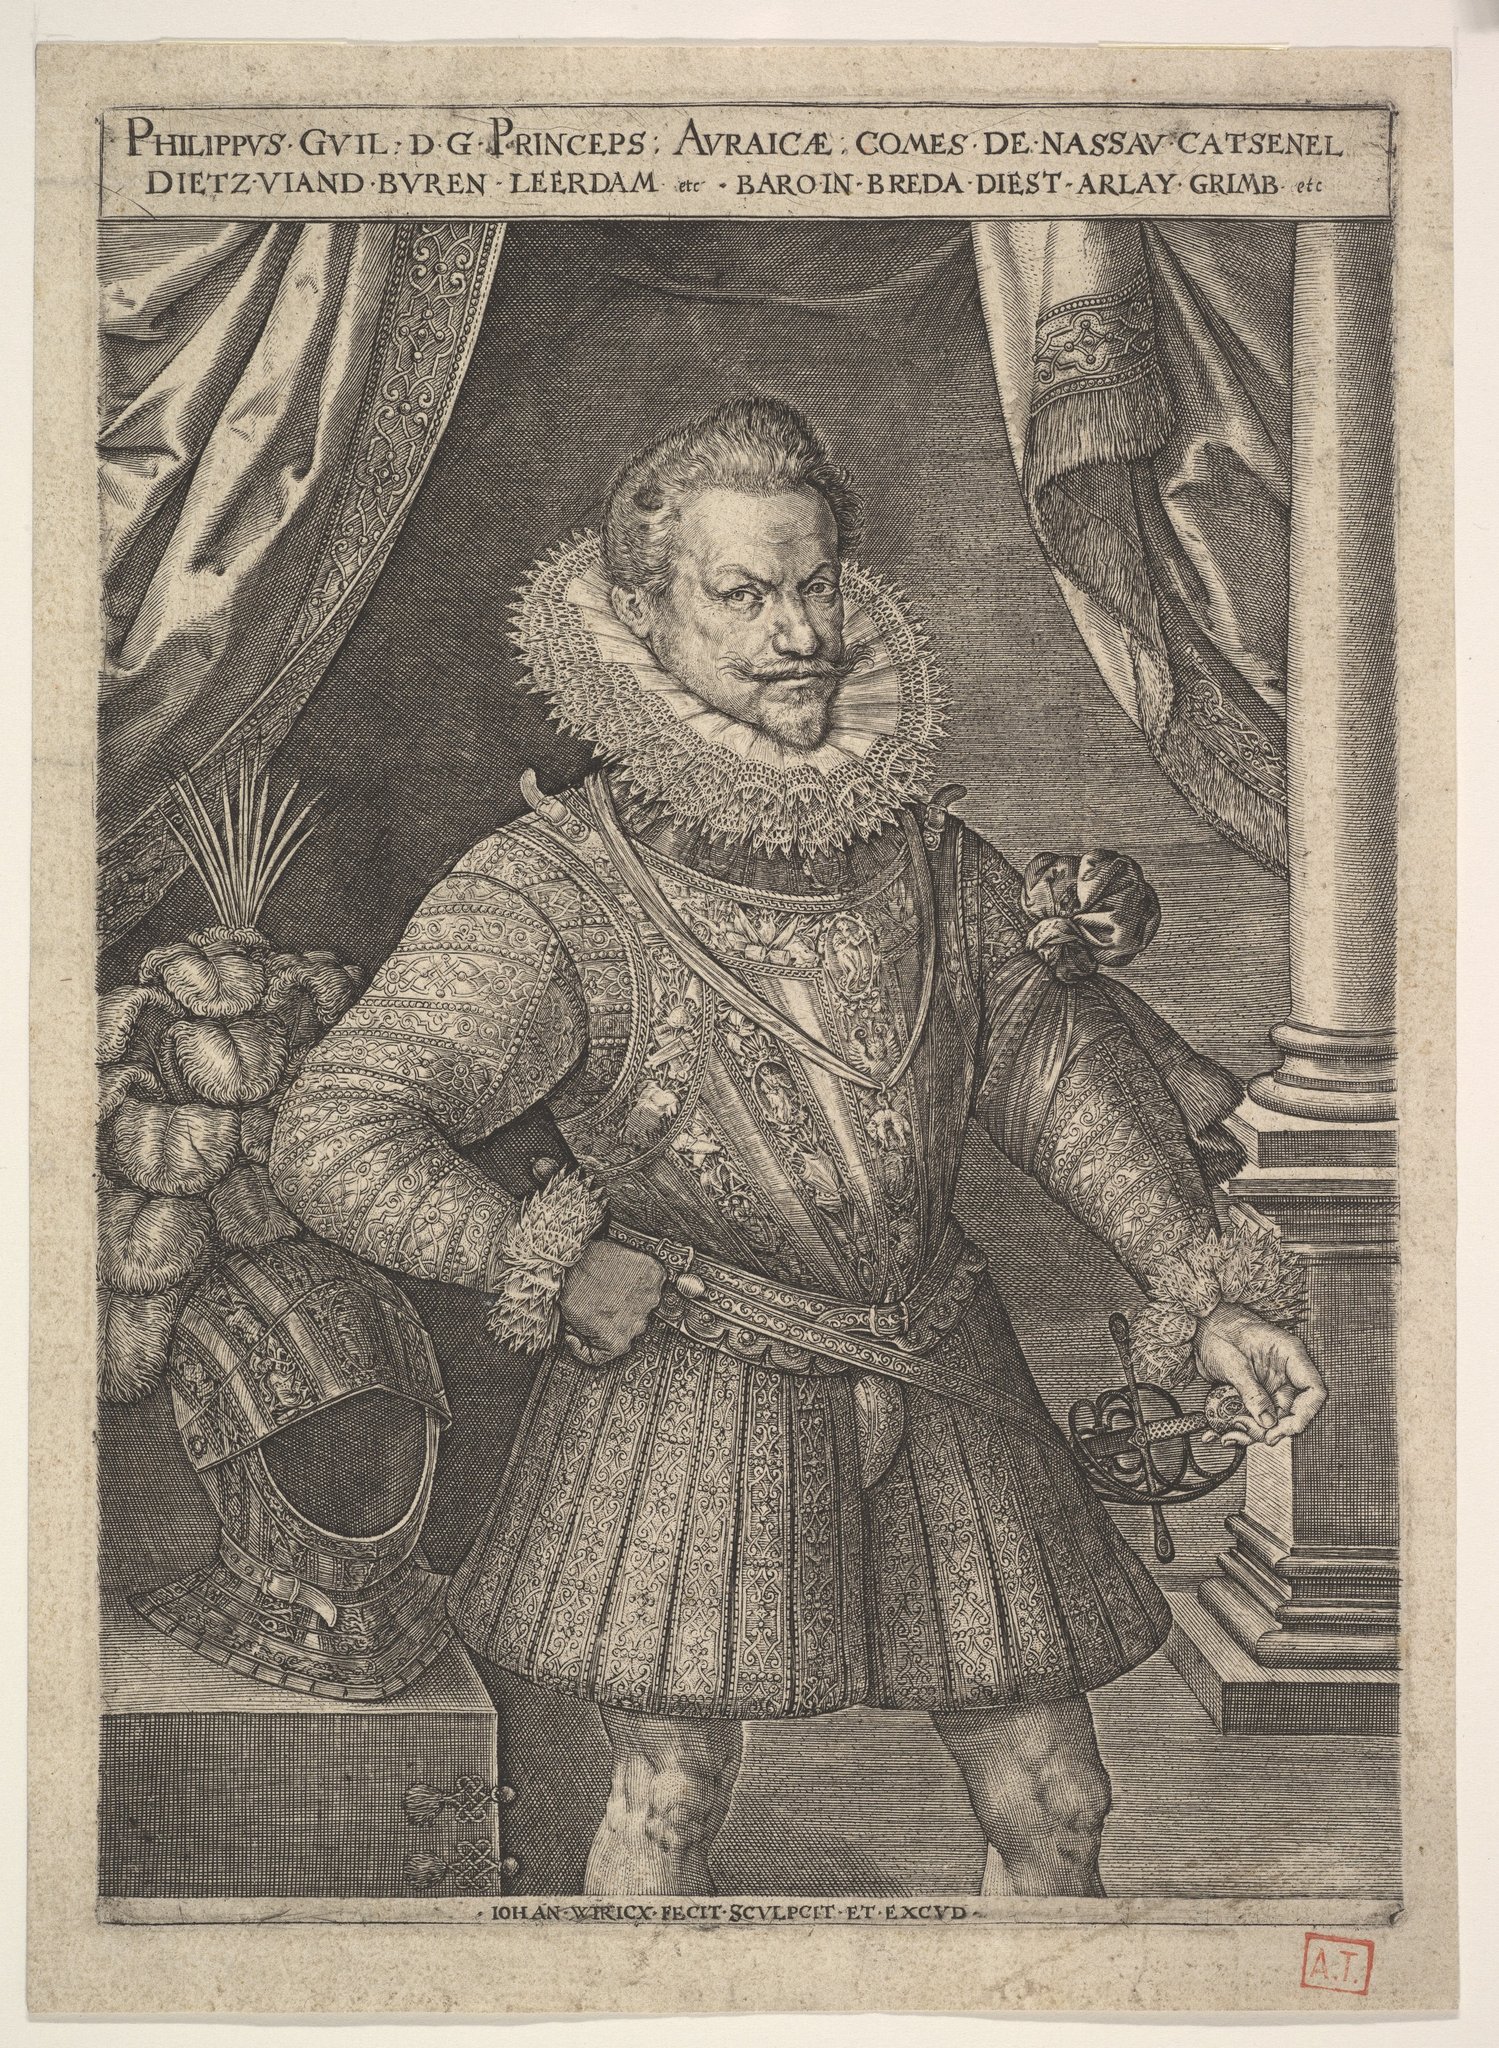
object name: print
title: Philip William of Orange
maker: jan (johannes) wierix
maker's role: artist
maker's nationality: netherlandish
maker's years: 1549-1615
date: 1563-1615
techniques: engraving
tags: helmets,men,portraits